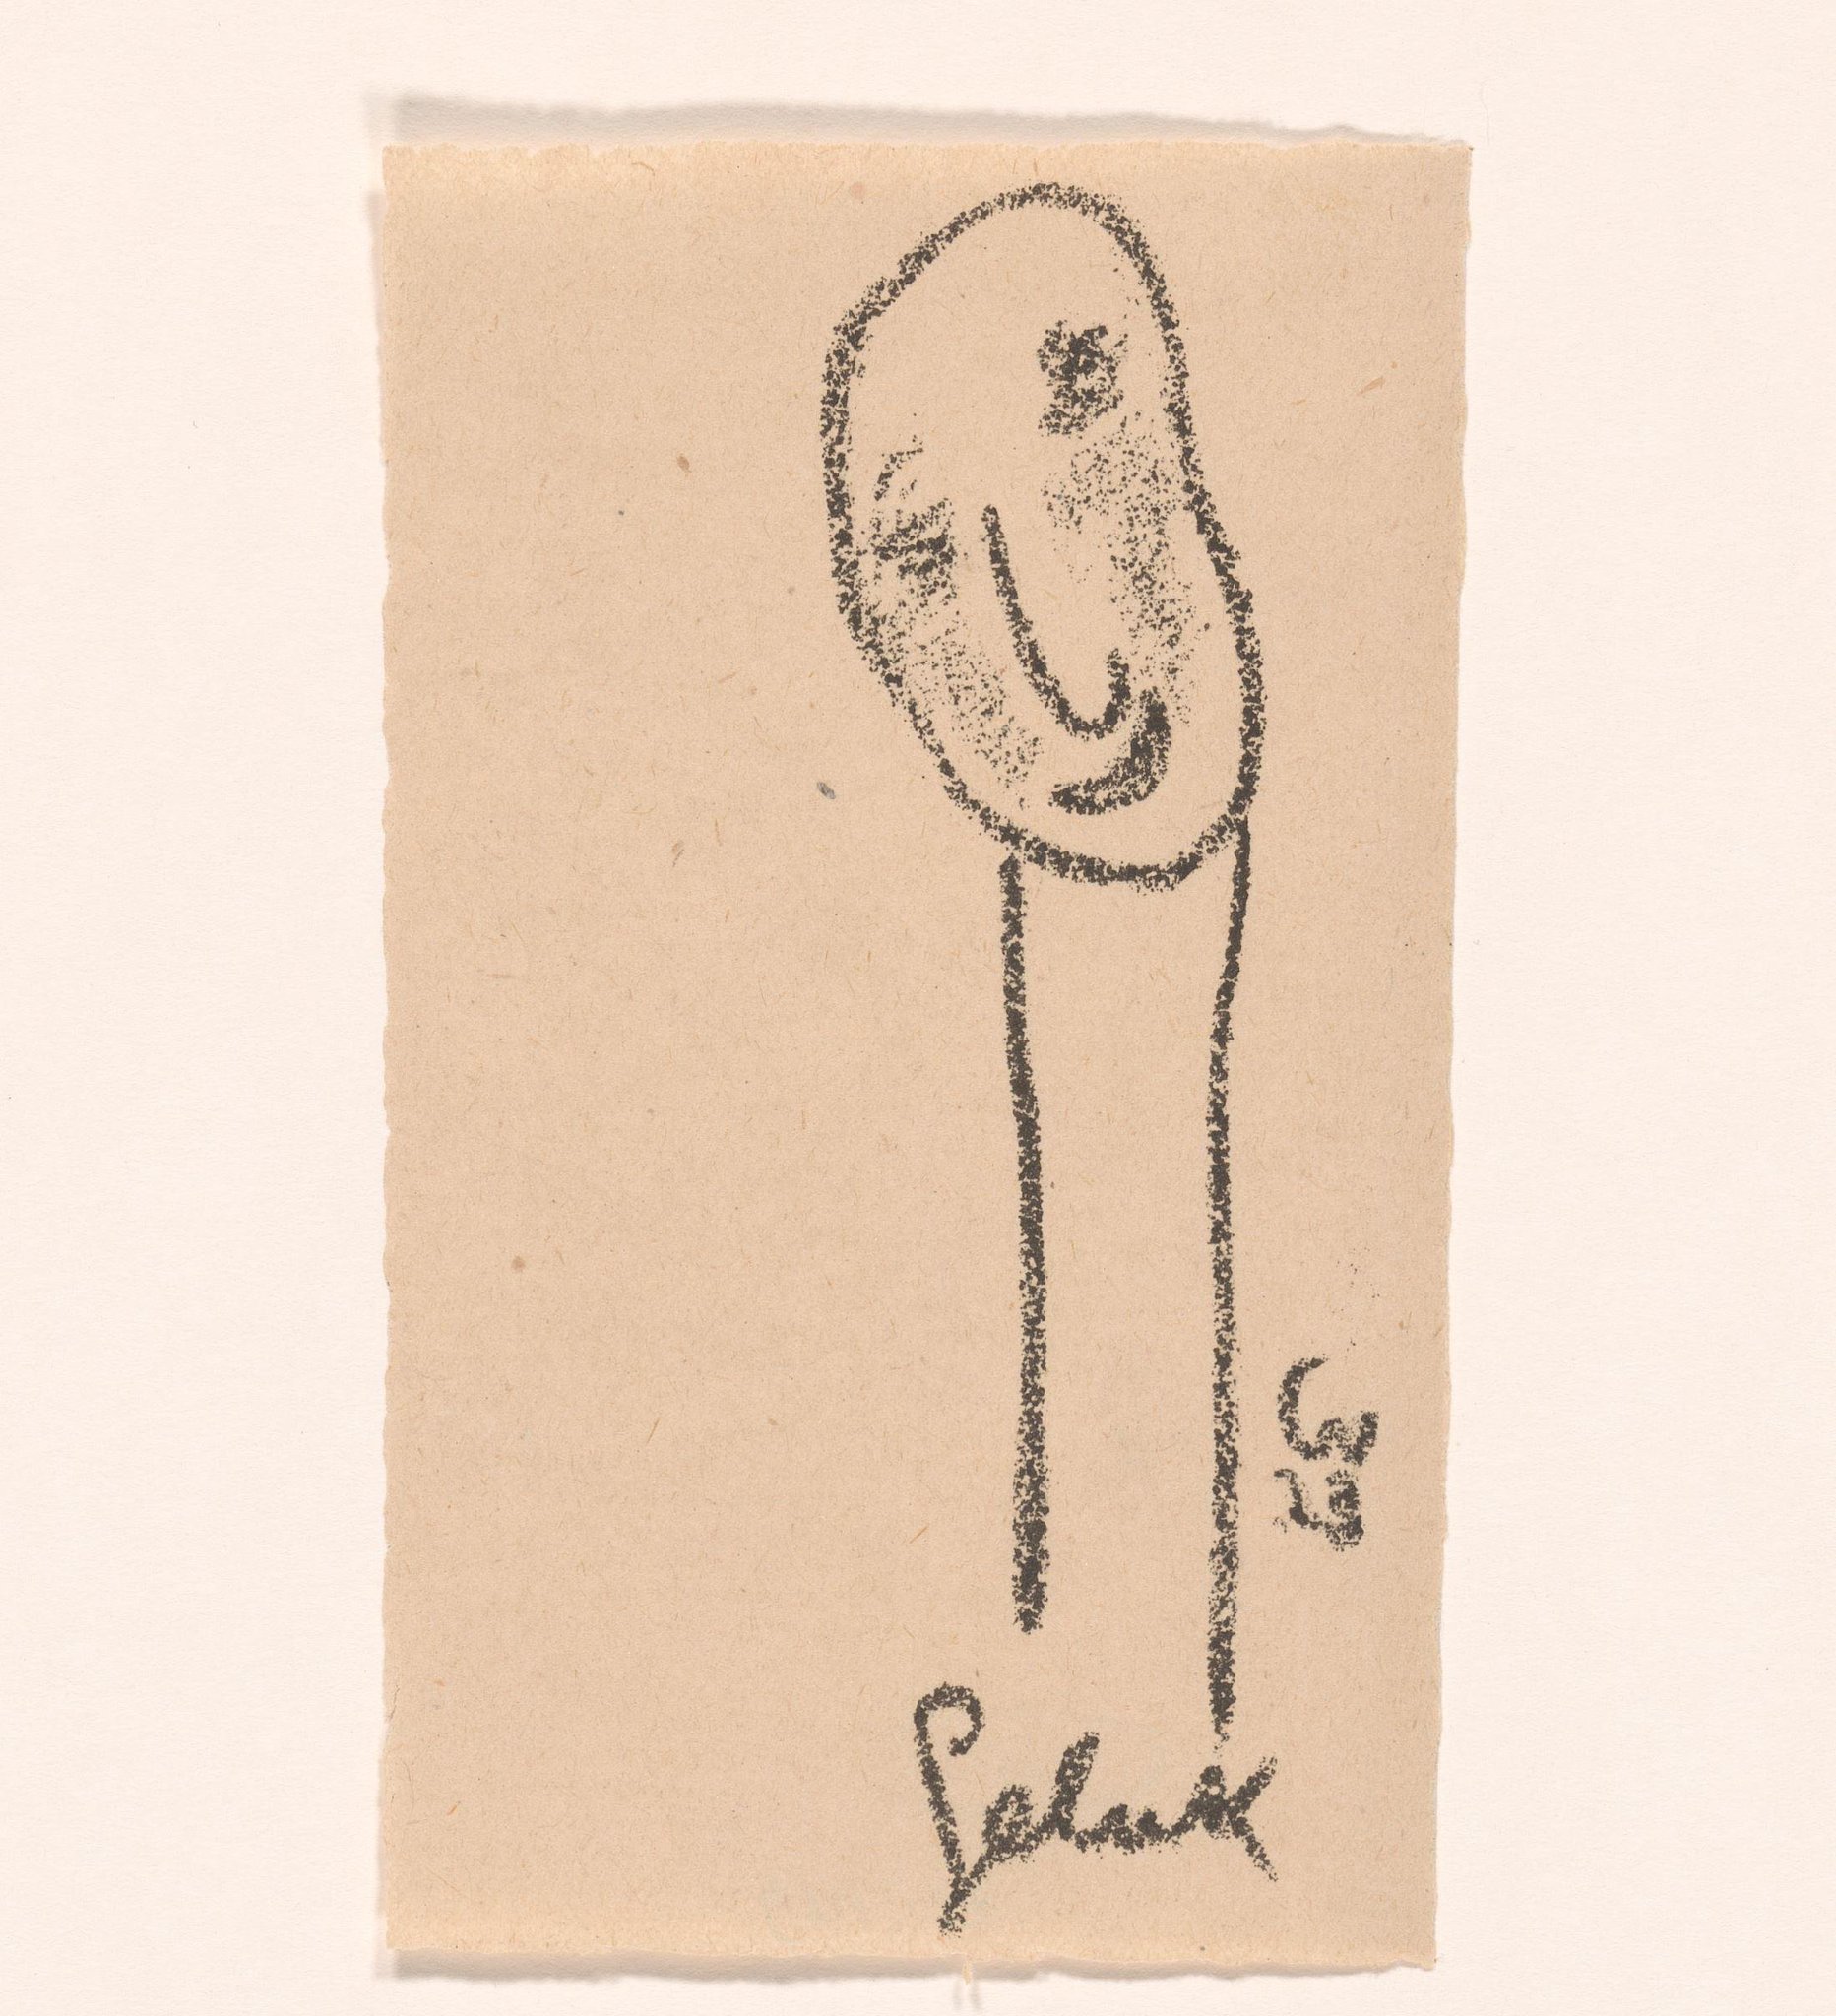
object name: print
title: Geluk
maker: erich wichmann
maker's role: print maker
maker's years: 1890-1929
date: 1923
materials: paper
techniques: lithograph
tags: caricatures (human types), happiness, felicity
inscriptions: collector's mark: Lugt 2228